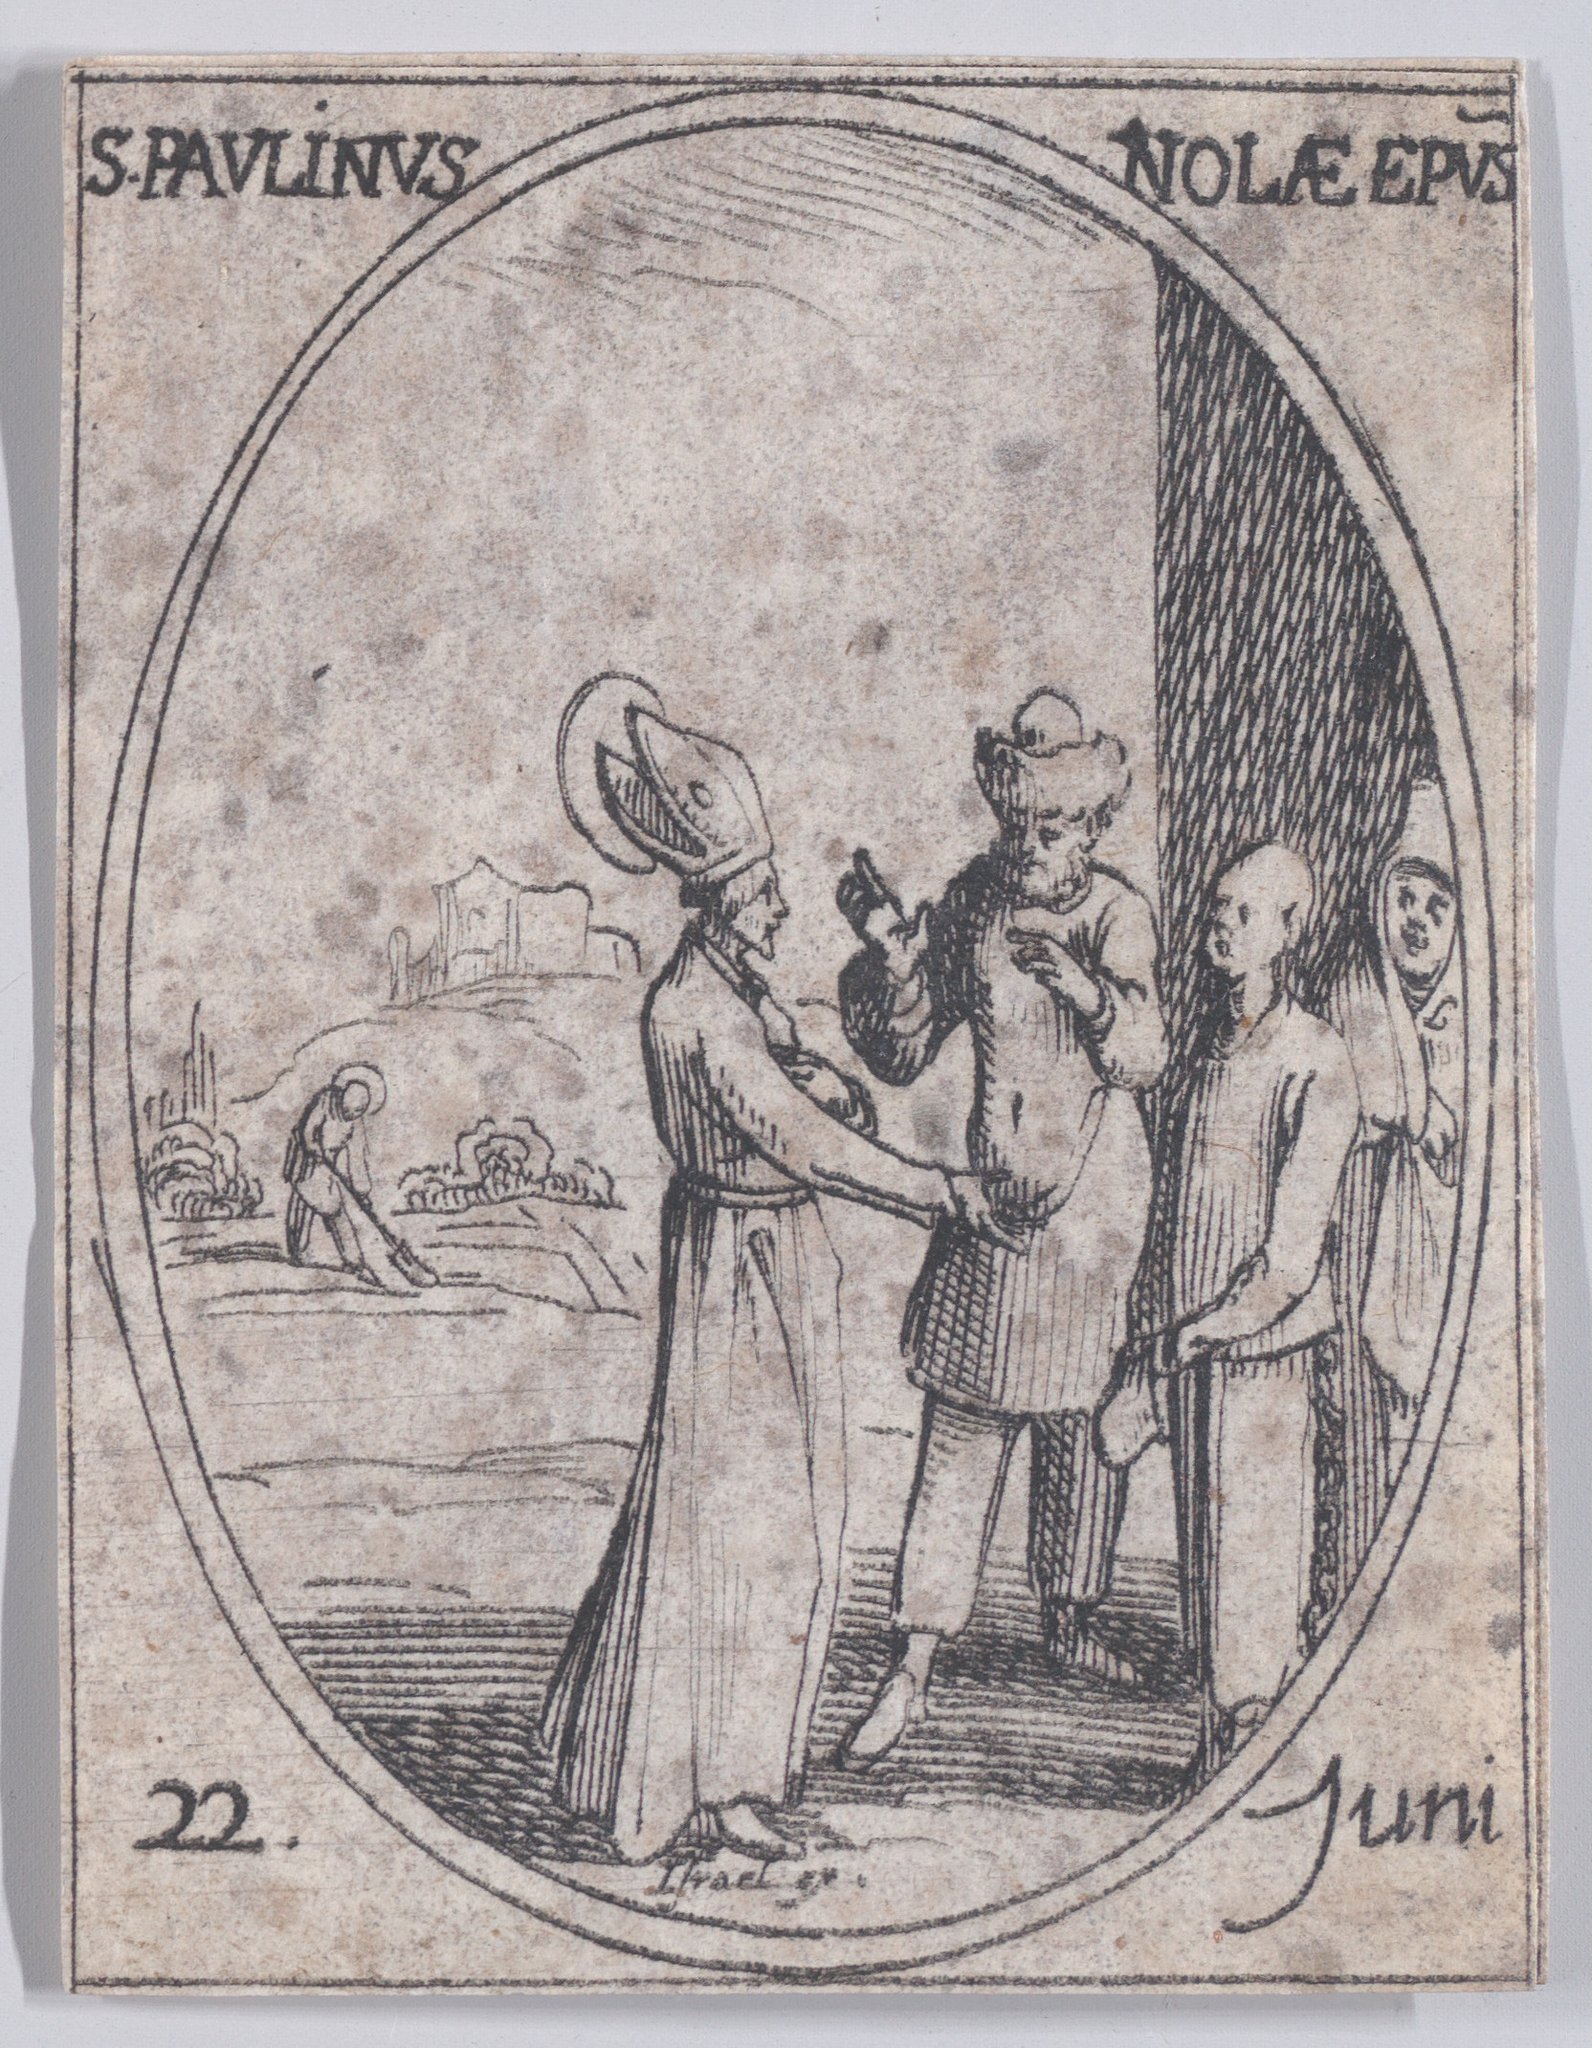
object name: print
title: S. Paulin, évêque de Nole (St. Paulinas, Bishop of Nolas), June 22nd, from "Les Images De Tous Les Saincts et Saintes de L'Année" (Images of All of the Saints and Religious Events of the Year)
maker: jacques callot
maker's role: artist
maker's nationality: french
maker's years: 1592-1635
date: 1636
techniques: etching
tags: men,saints